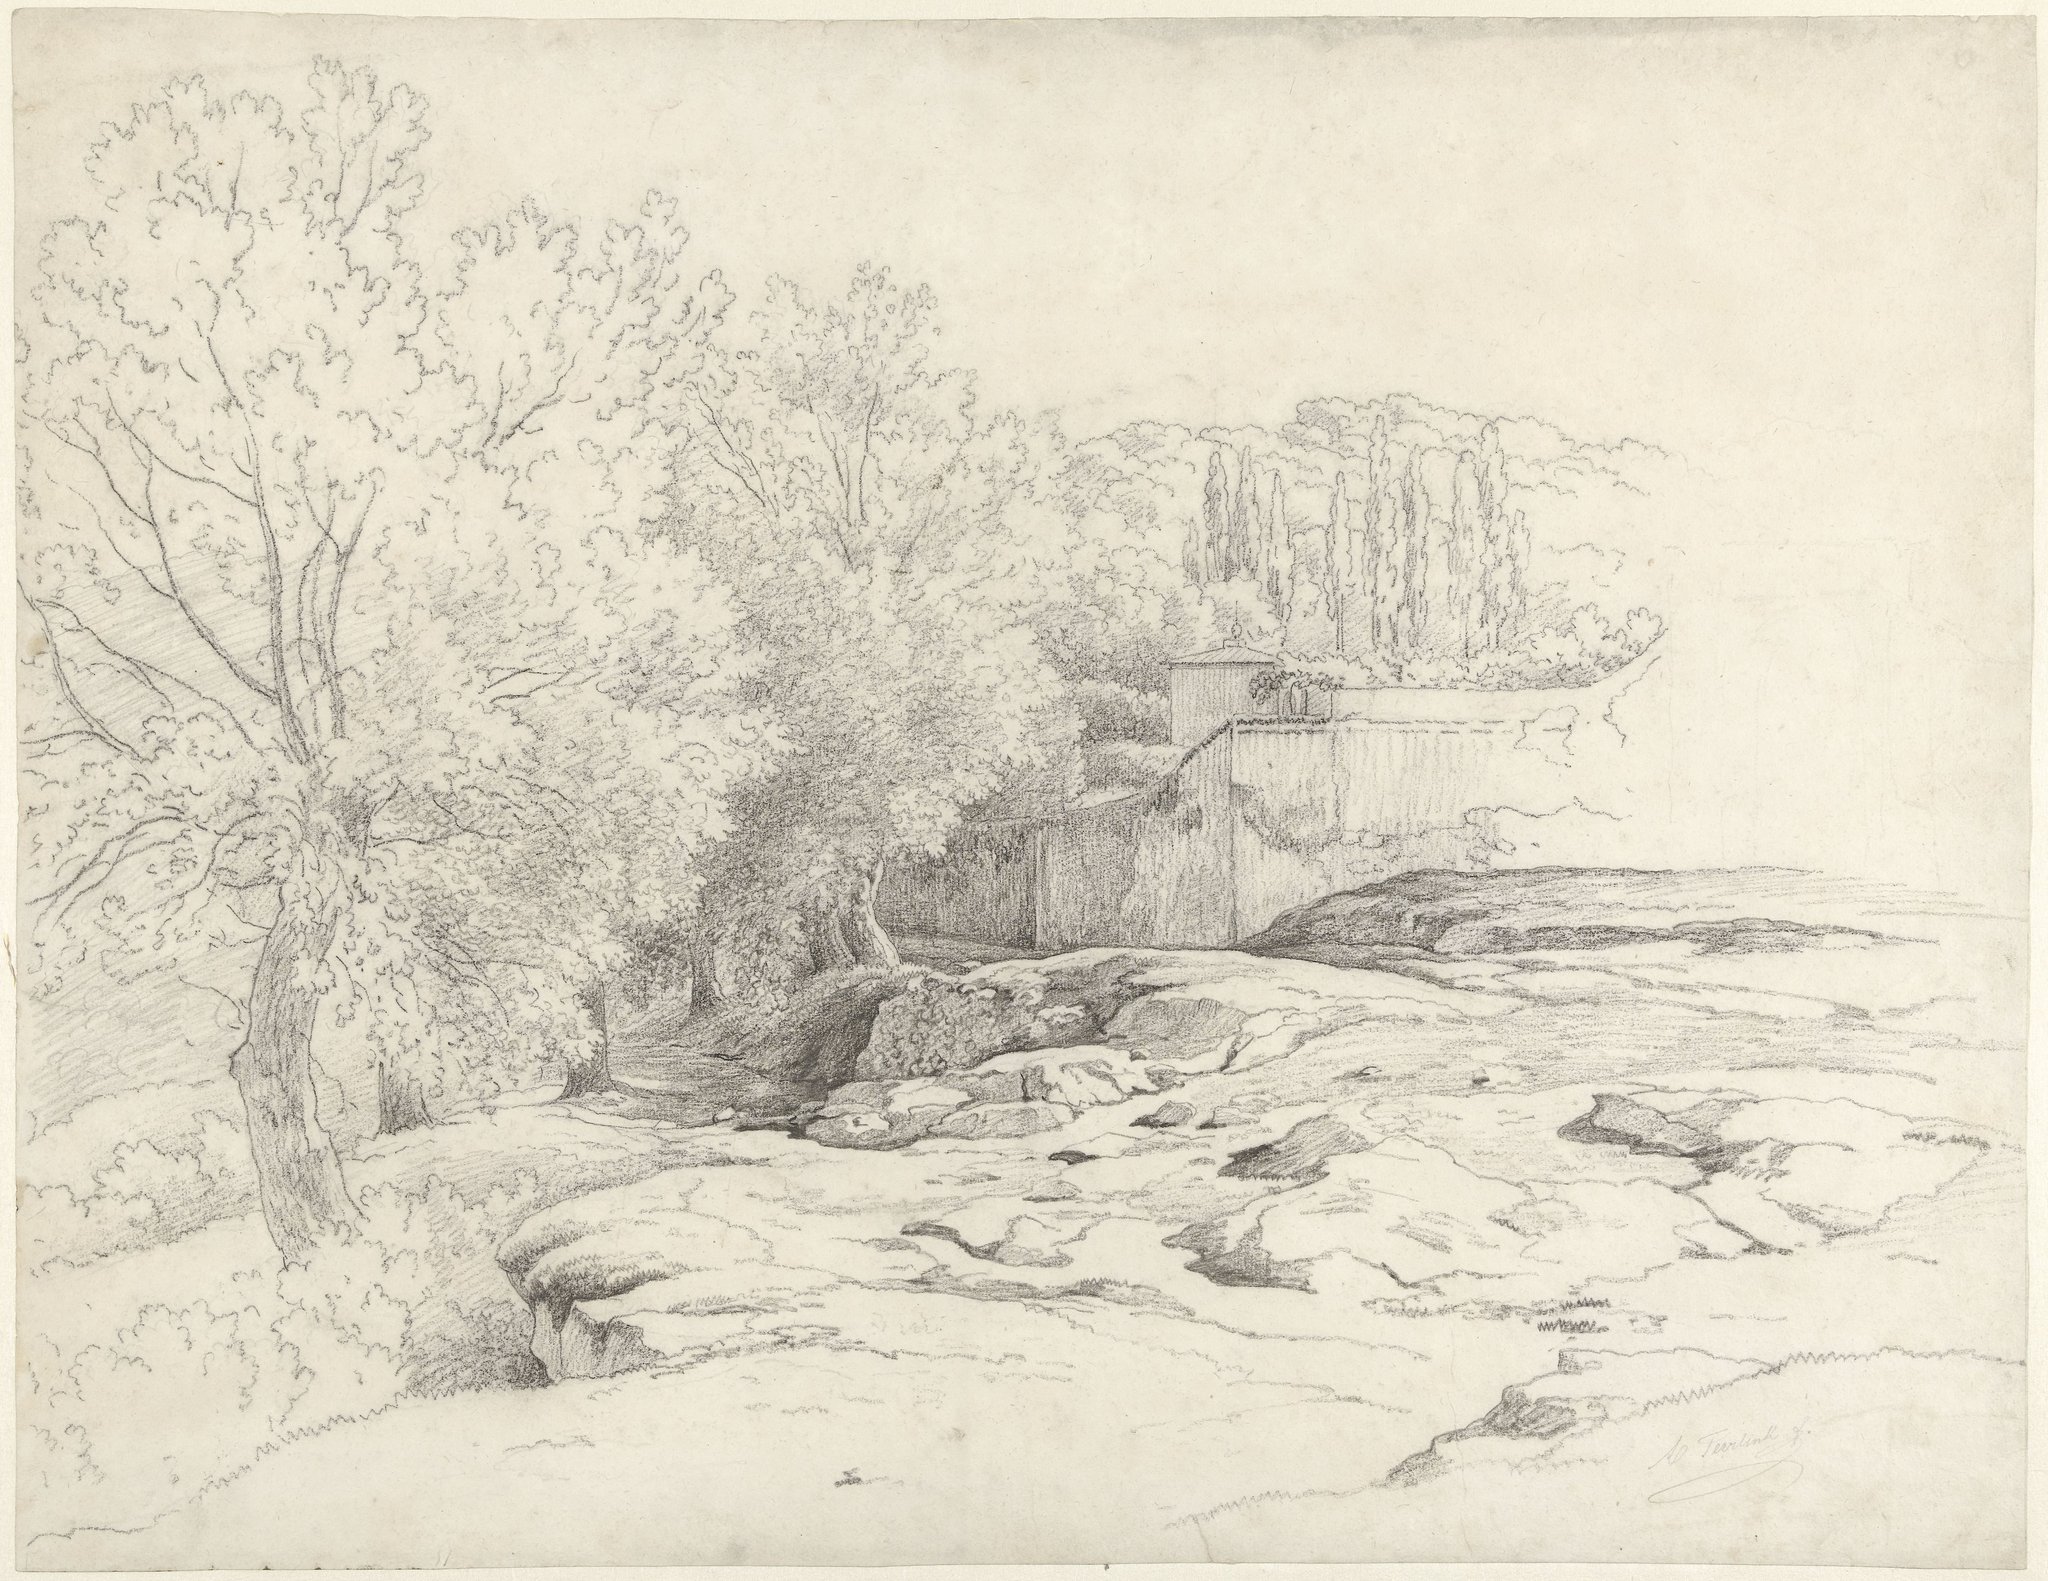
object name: drawing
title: Landschapsstudie met gebouwen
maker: abraham teerlink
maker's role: draughtsman, painter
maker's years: 1776-1857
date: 1786-1857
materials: chalk, paper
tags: landscapes, italy